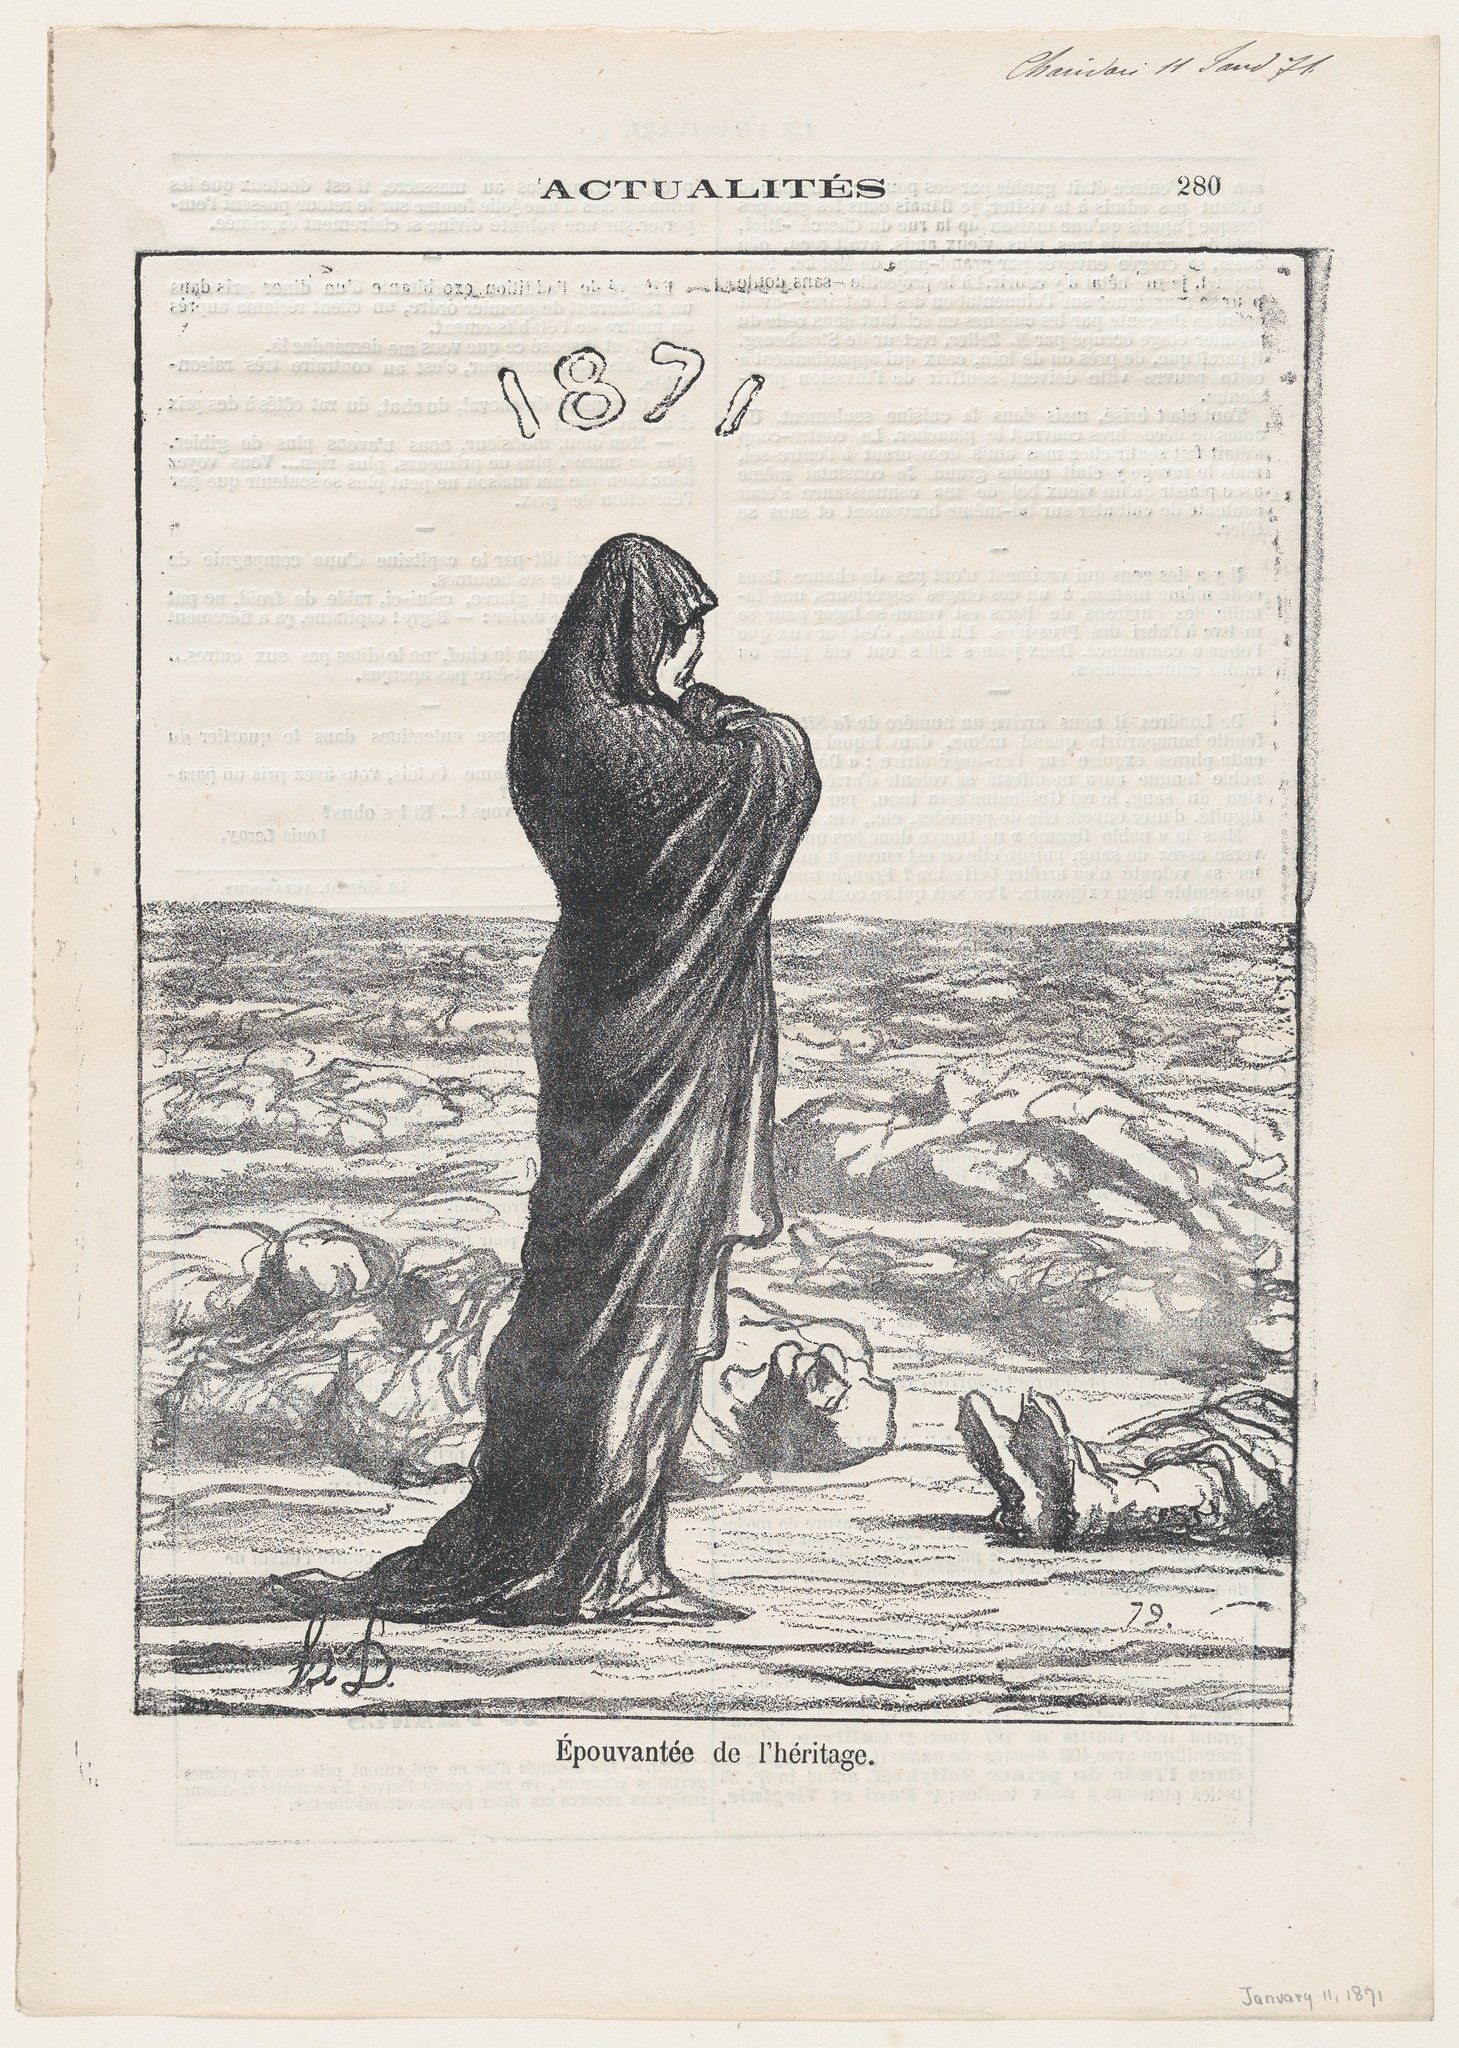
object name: print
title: Dismayed with her legacy, from 'News of the day,' published in Le Charivari, January 11, 1871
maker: honoré daumier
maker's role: artist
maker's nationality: french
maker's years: 1808-1879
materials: paper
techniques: lithograph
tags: corpses,women